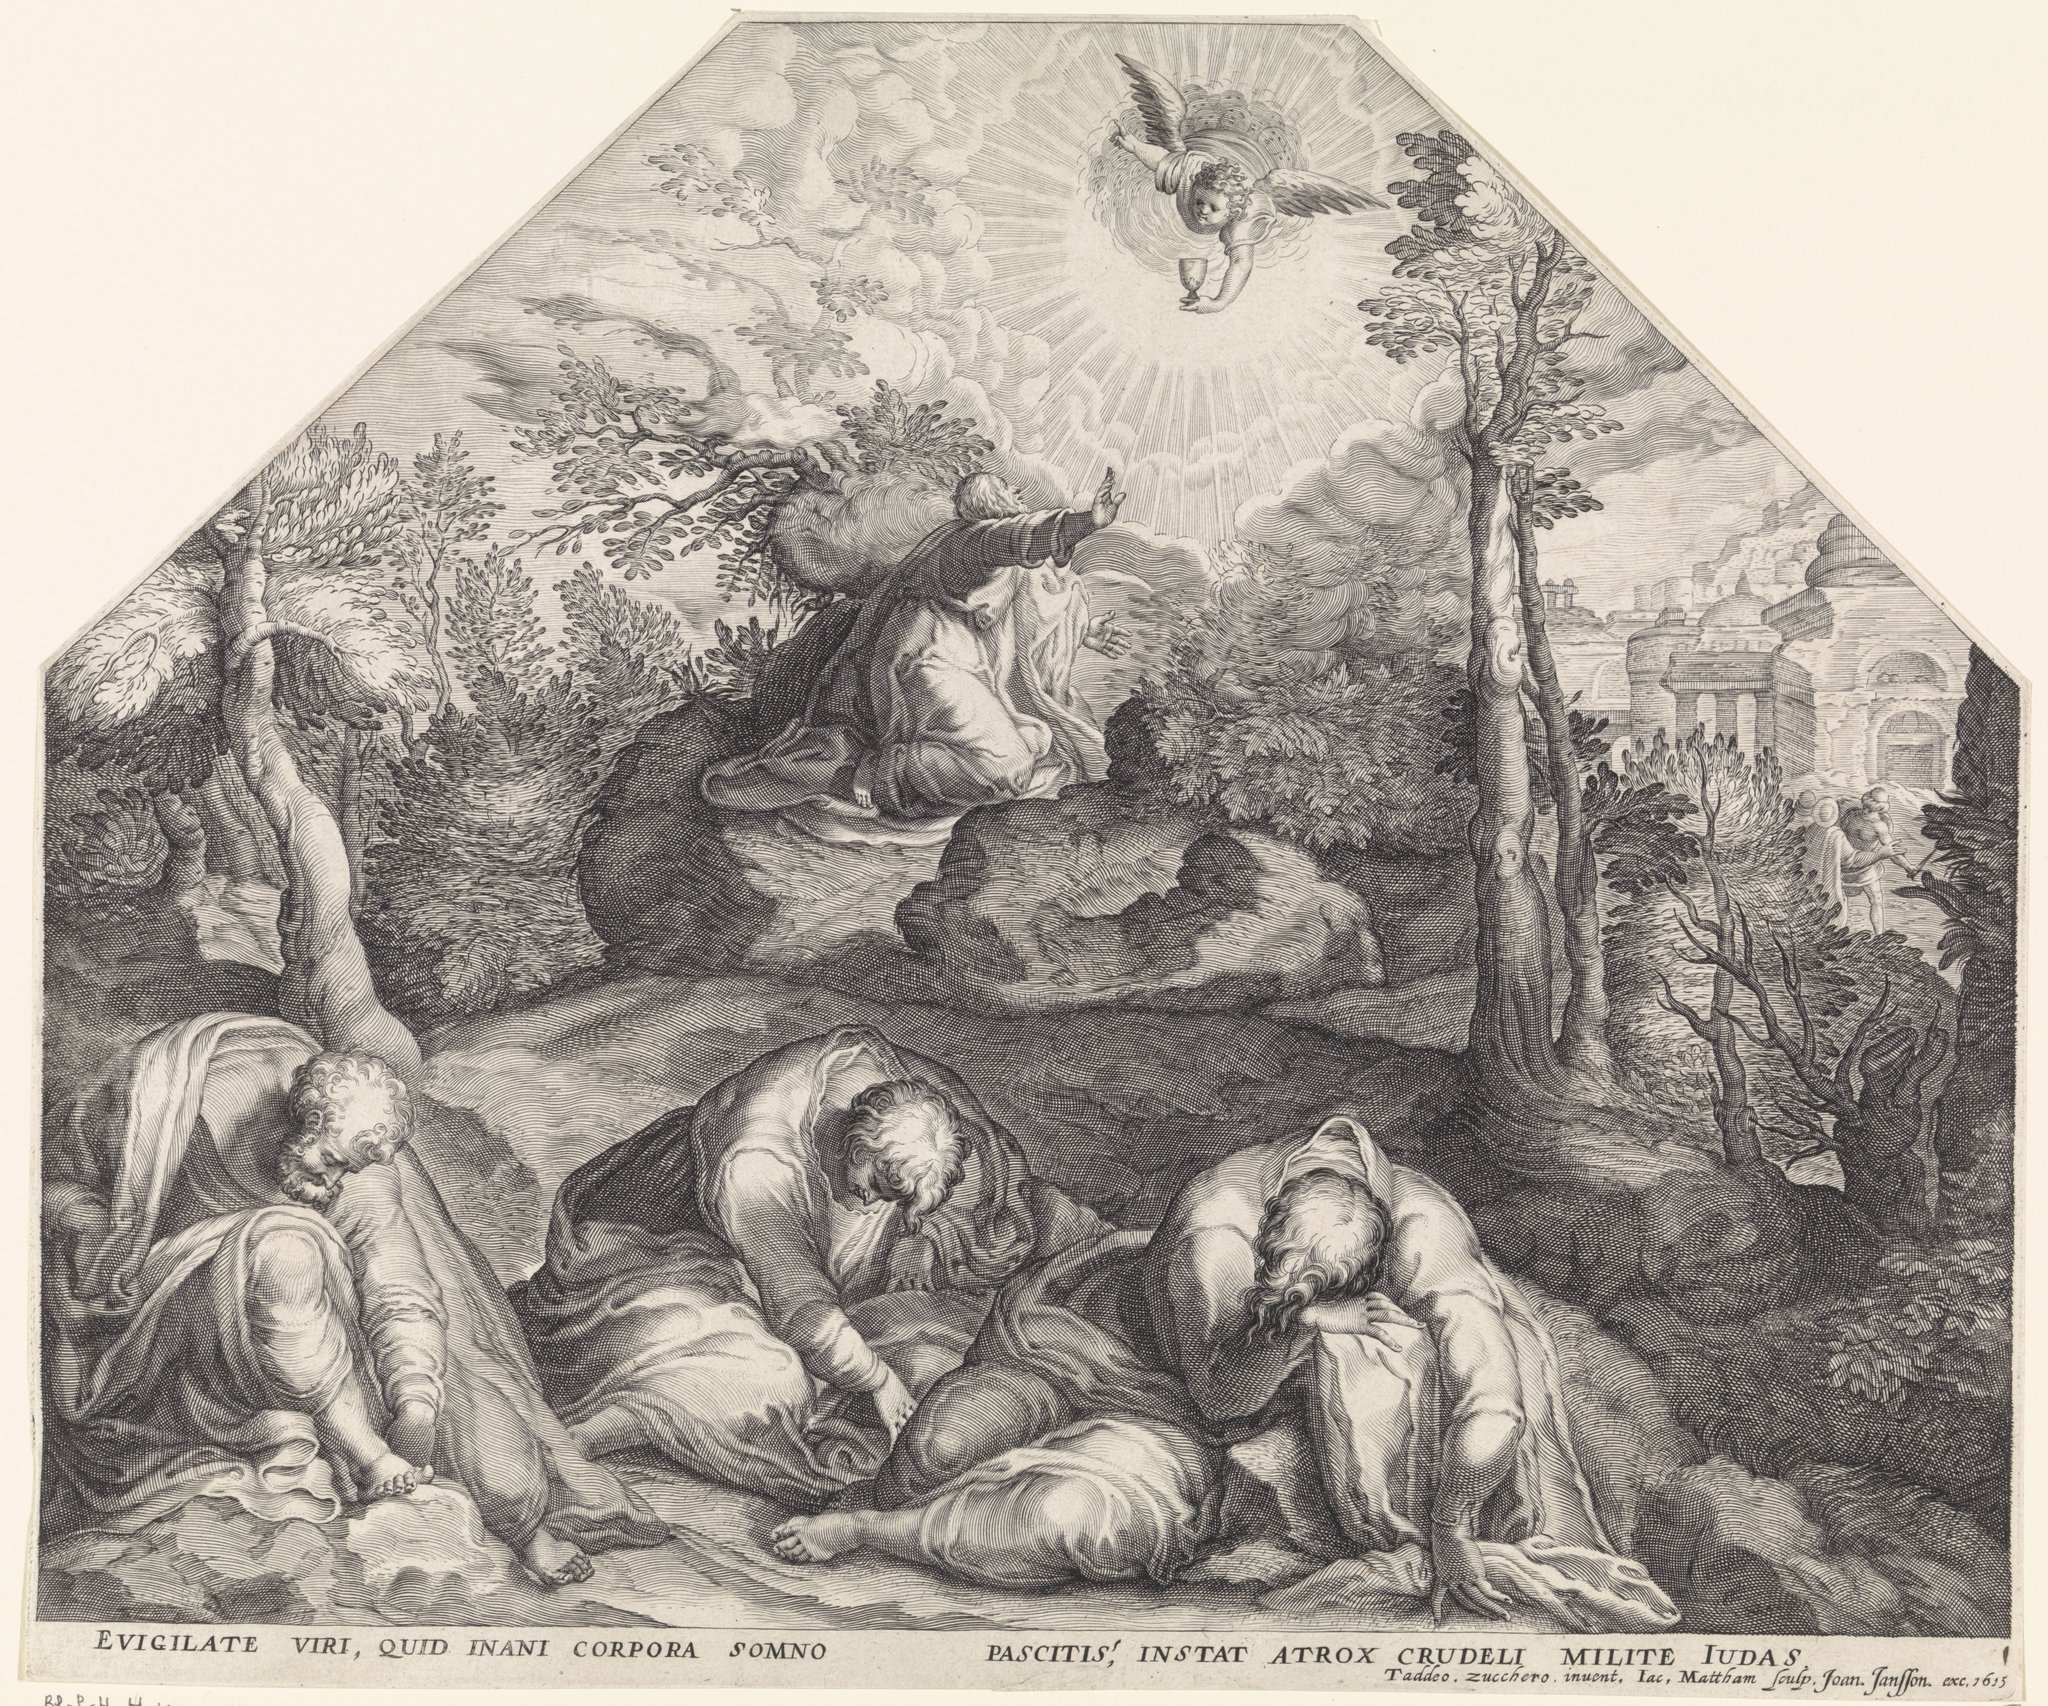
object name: print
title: Christus in de hof van Getsemane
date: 1615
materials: paper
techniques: engraving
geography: amsterdam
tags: christ's prayer in the garden of gethsemane during the night, angel(s) with chalice, agony of christ: to comfort him one or more angels appear to christ with chalice and/or cross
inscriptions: collector's mark: Lugt 10, collector's mark: Lugt 11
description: Christus in de hof van Getsemane, met een engel die aan hem verschijnt met een miskelk. Op de voorgrond de slapende apostelen.